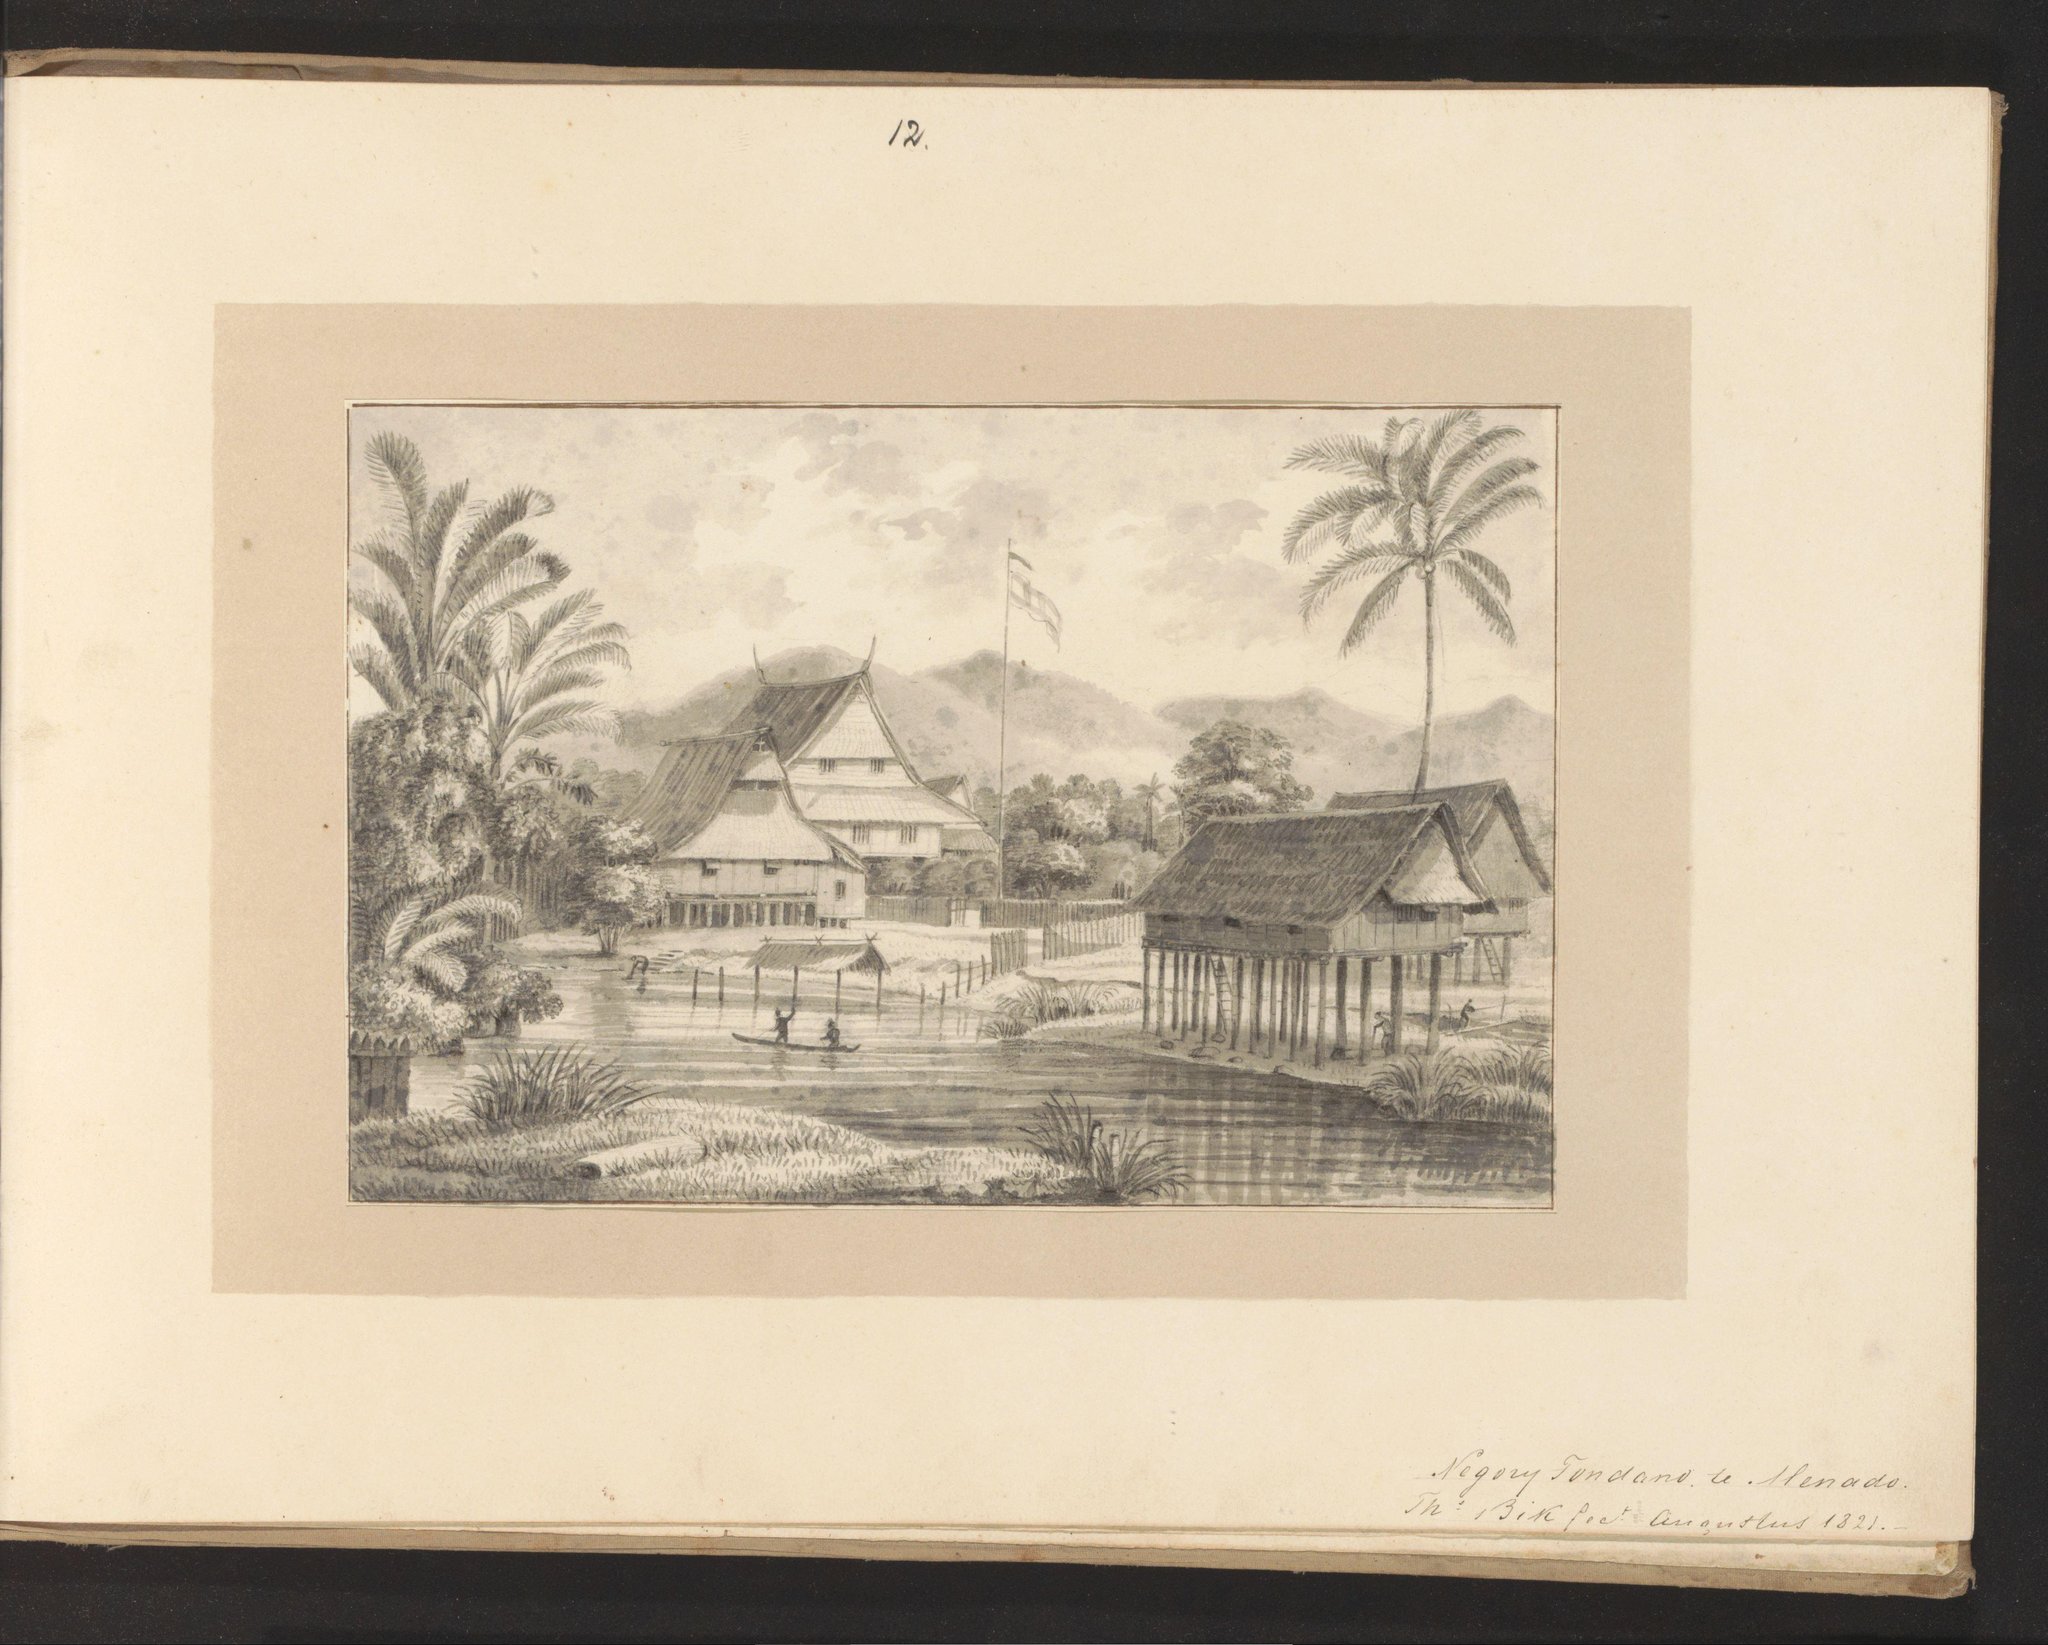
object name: album leaf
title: Tondano, dorp op Manado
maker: jannes theodorus bik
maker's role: draughtsman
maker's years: 1796-1872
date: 1808-1821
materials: chalk, ink, paper, pencil, watercolor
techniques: brush, pen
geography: manado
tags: prospect of village, silhouette of village, landscapes with waters, waterscapes, seascapes (in the temperate zone), mountains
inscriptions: annotation: ‘Negoy Tondano te Menado.’, signature and date: ‘Th. Bik fect Augustus 1821.-’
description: Blad 12 uit een album met 14 tekeningen en een prent.